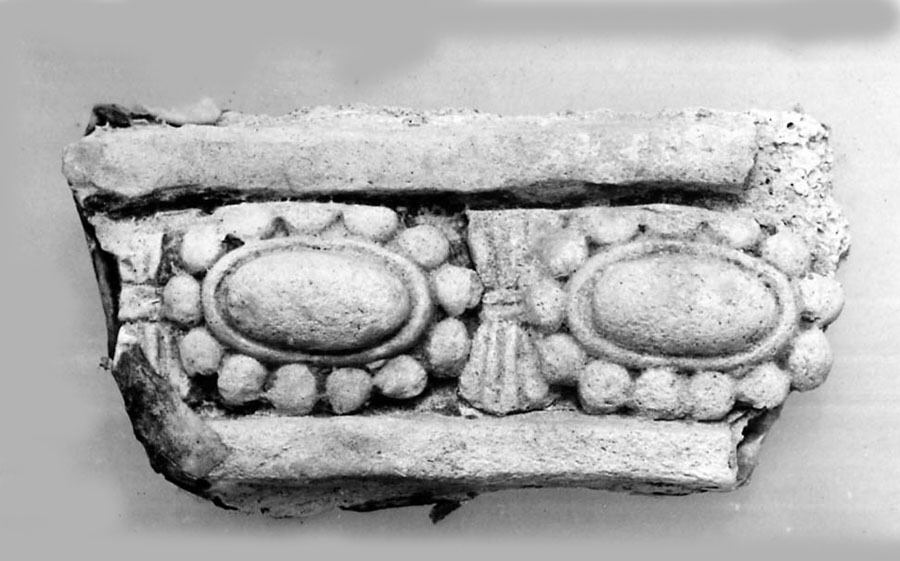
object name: relief fragment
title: Fragment of a Relief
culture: central asian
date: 601-800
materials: plaster